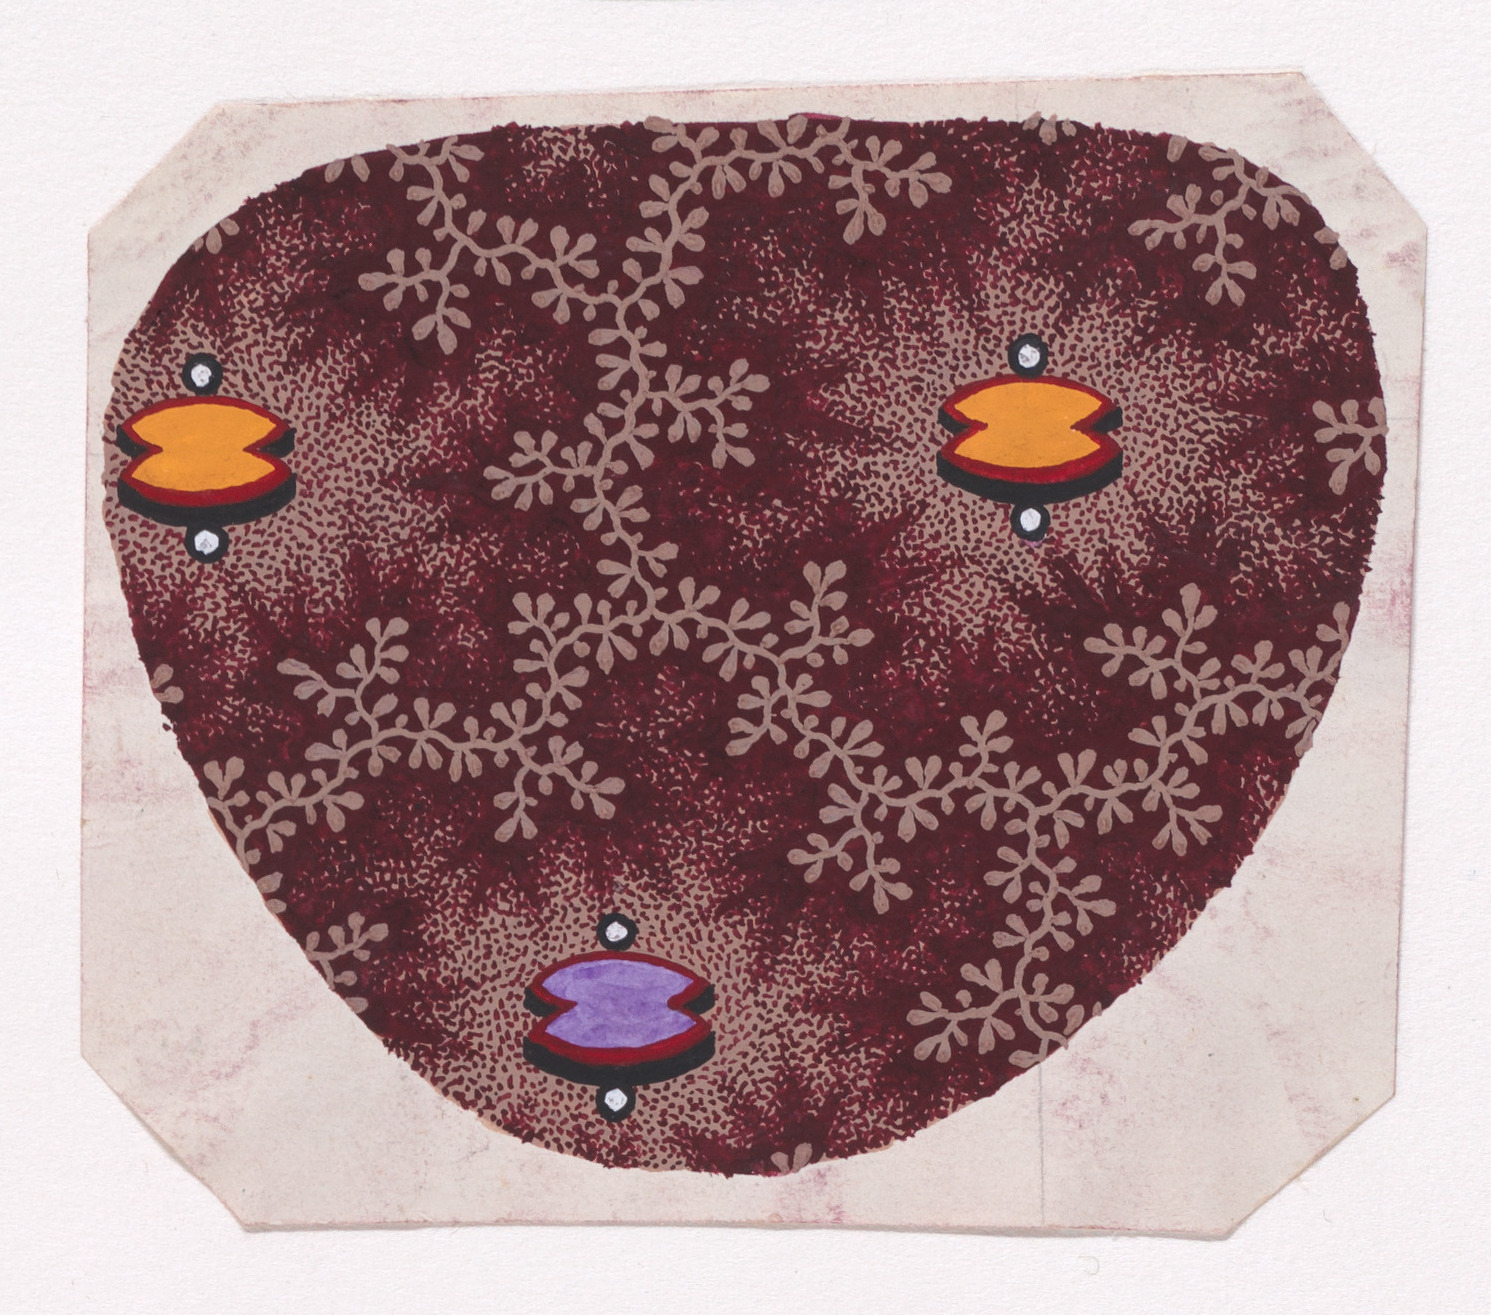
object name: drawing ornament architecture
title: Textile Design with Alternating Rows of Curved Hourglass Shapes Flanked by Two Pearls Framed with Garlands of Stylized Leaves with Offsetting Thorns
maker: anonymous, alsatian, 19th century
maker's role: artist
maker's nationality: alsatian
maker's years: 1800-1900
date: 1840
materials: gouache